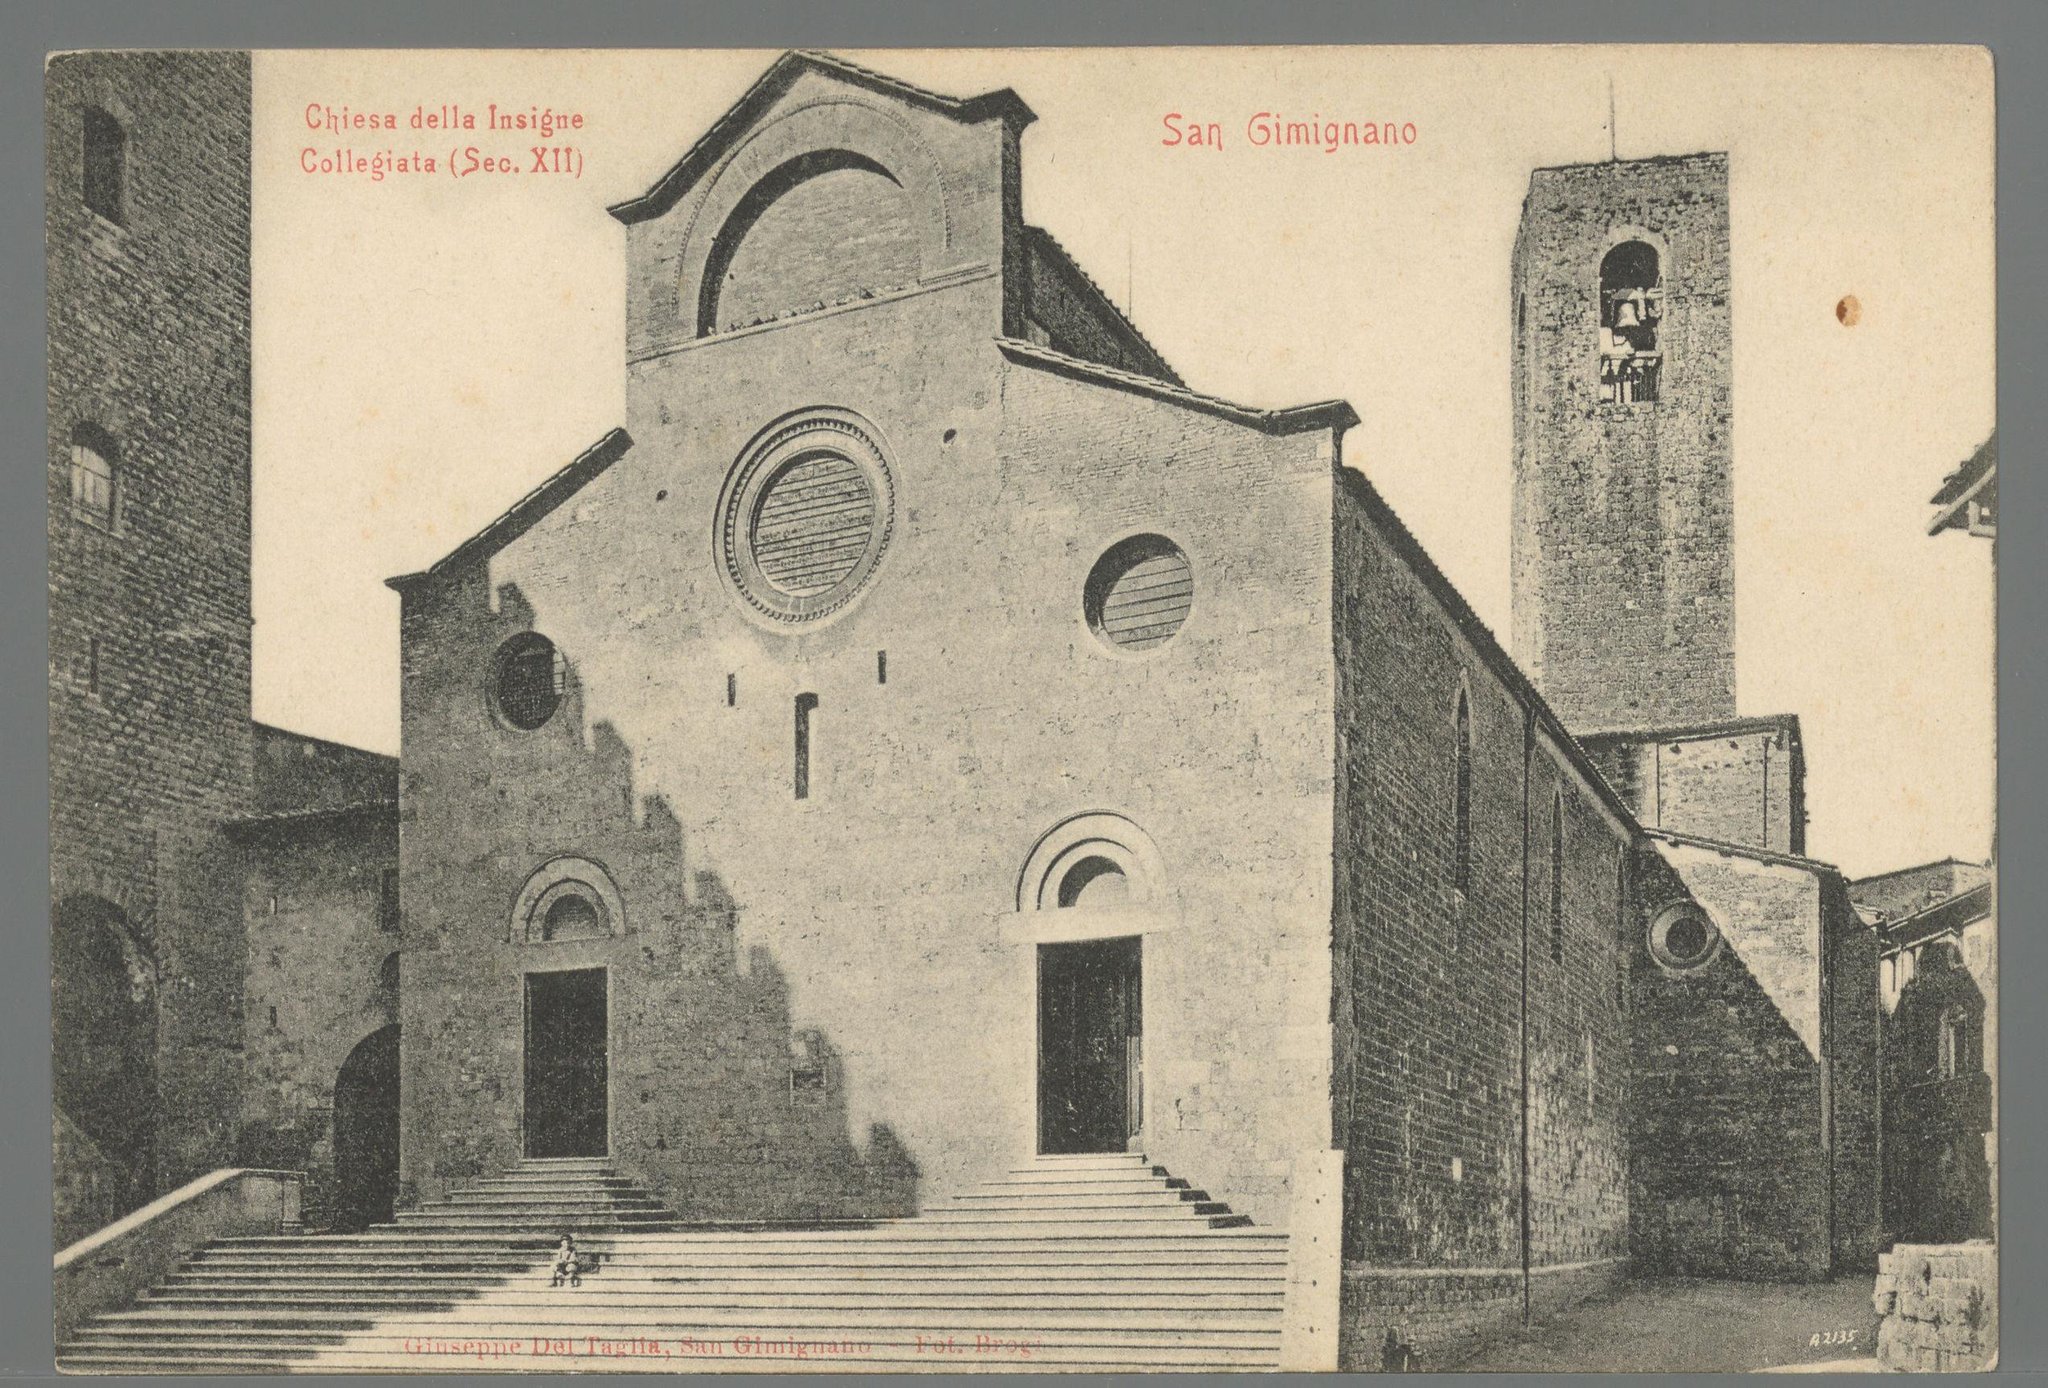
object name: ansichtkaart, prentbriefkaart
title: Chiesa della Insigne Collegiata (Sec. XII). San Gimignano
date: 1889-1906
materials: cardboard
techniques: photograph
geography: san gimignano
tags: church (exterior)